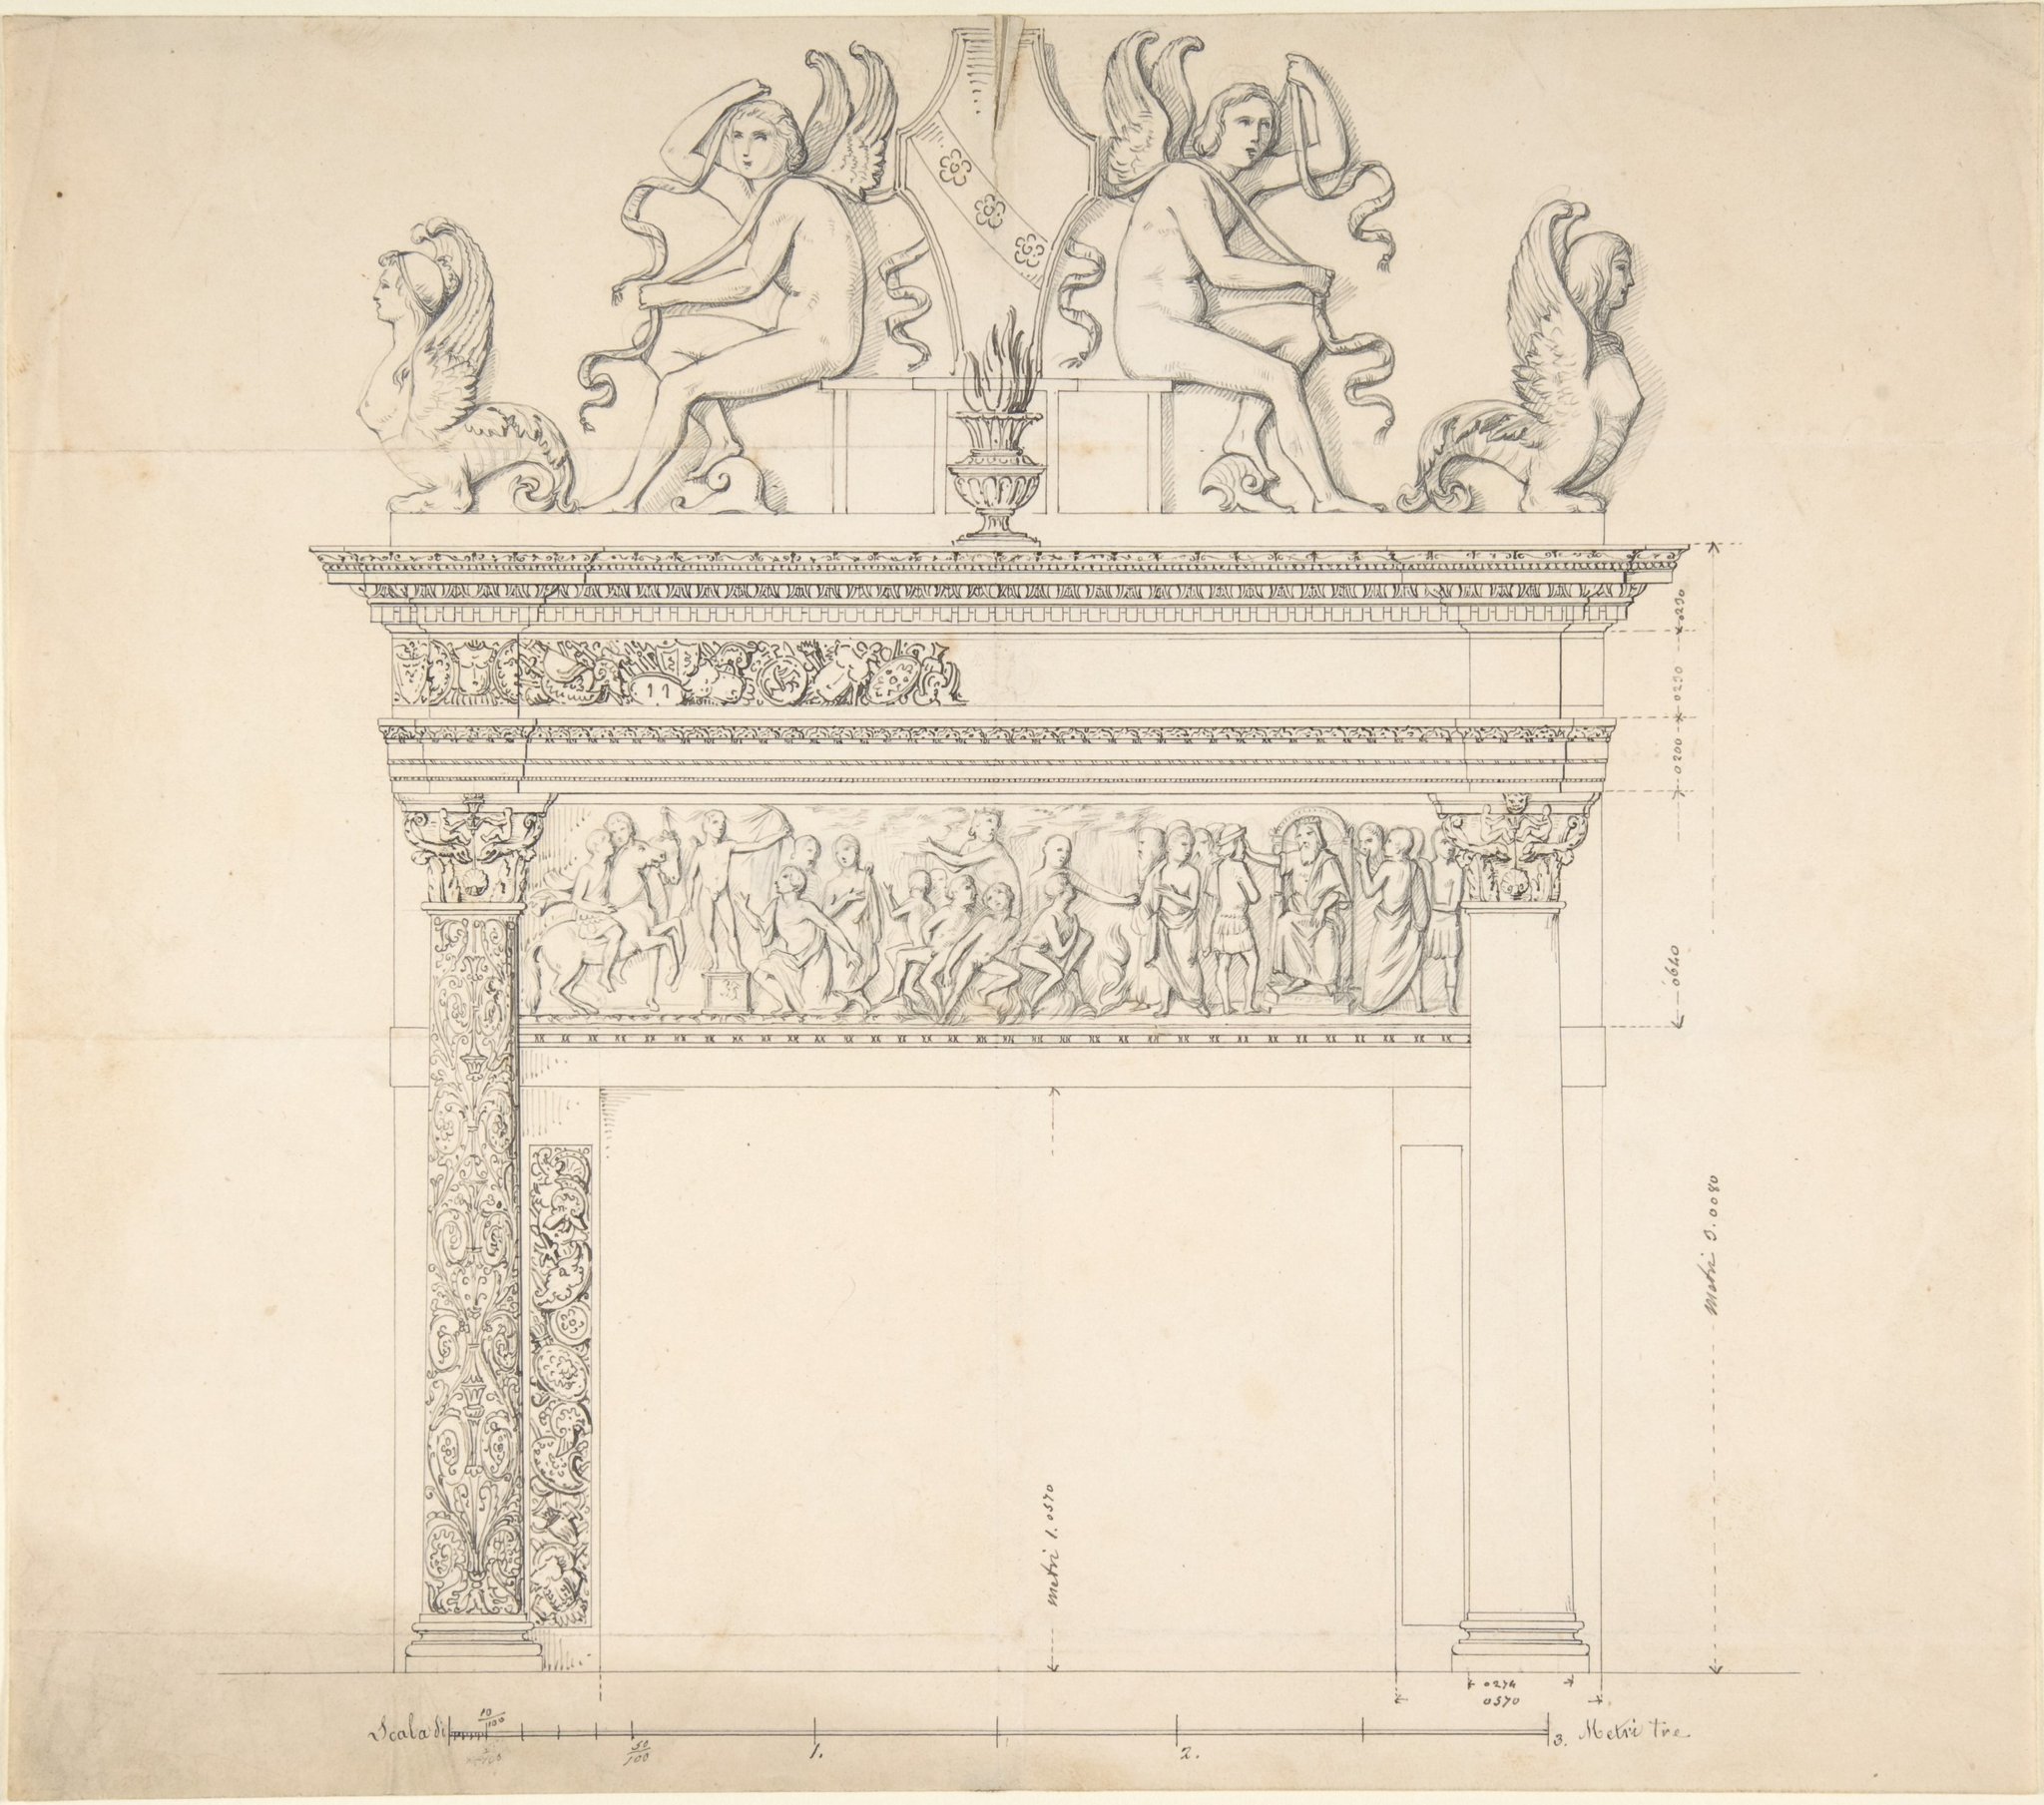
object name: drawing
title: Design for a Chimney Piece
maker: anonymous, italian, 19th century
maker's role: artist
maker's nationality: italian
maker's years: 1800-1900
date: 1800-1900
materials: ink, pencil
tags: human figures,fireplaces